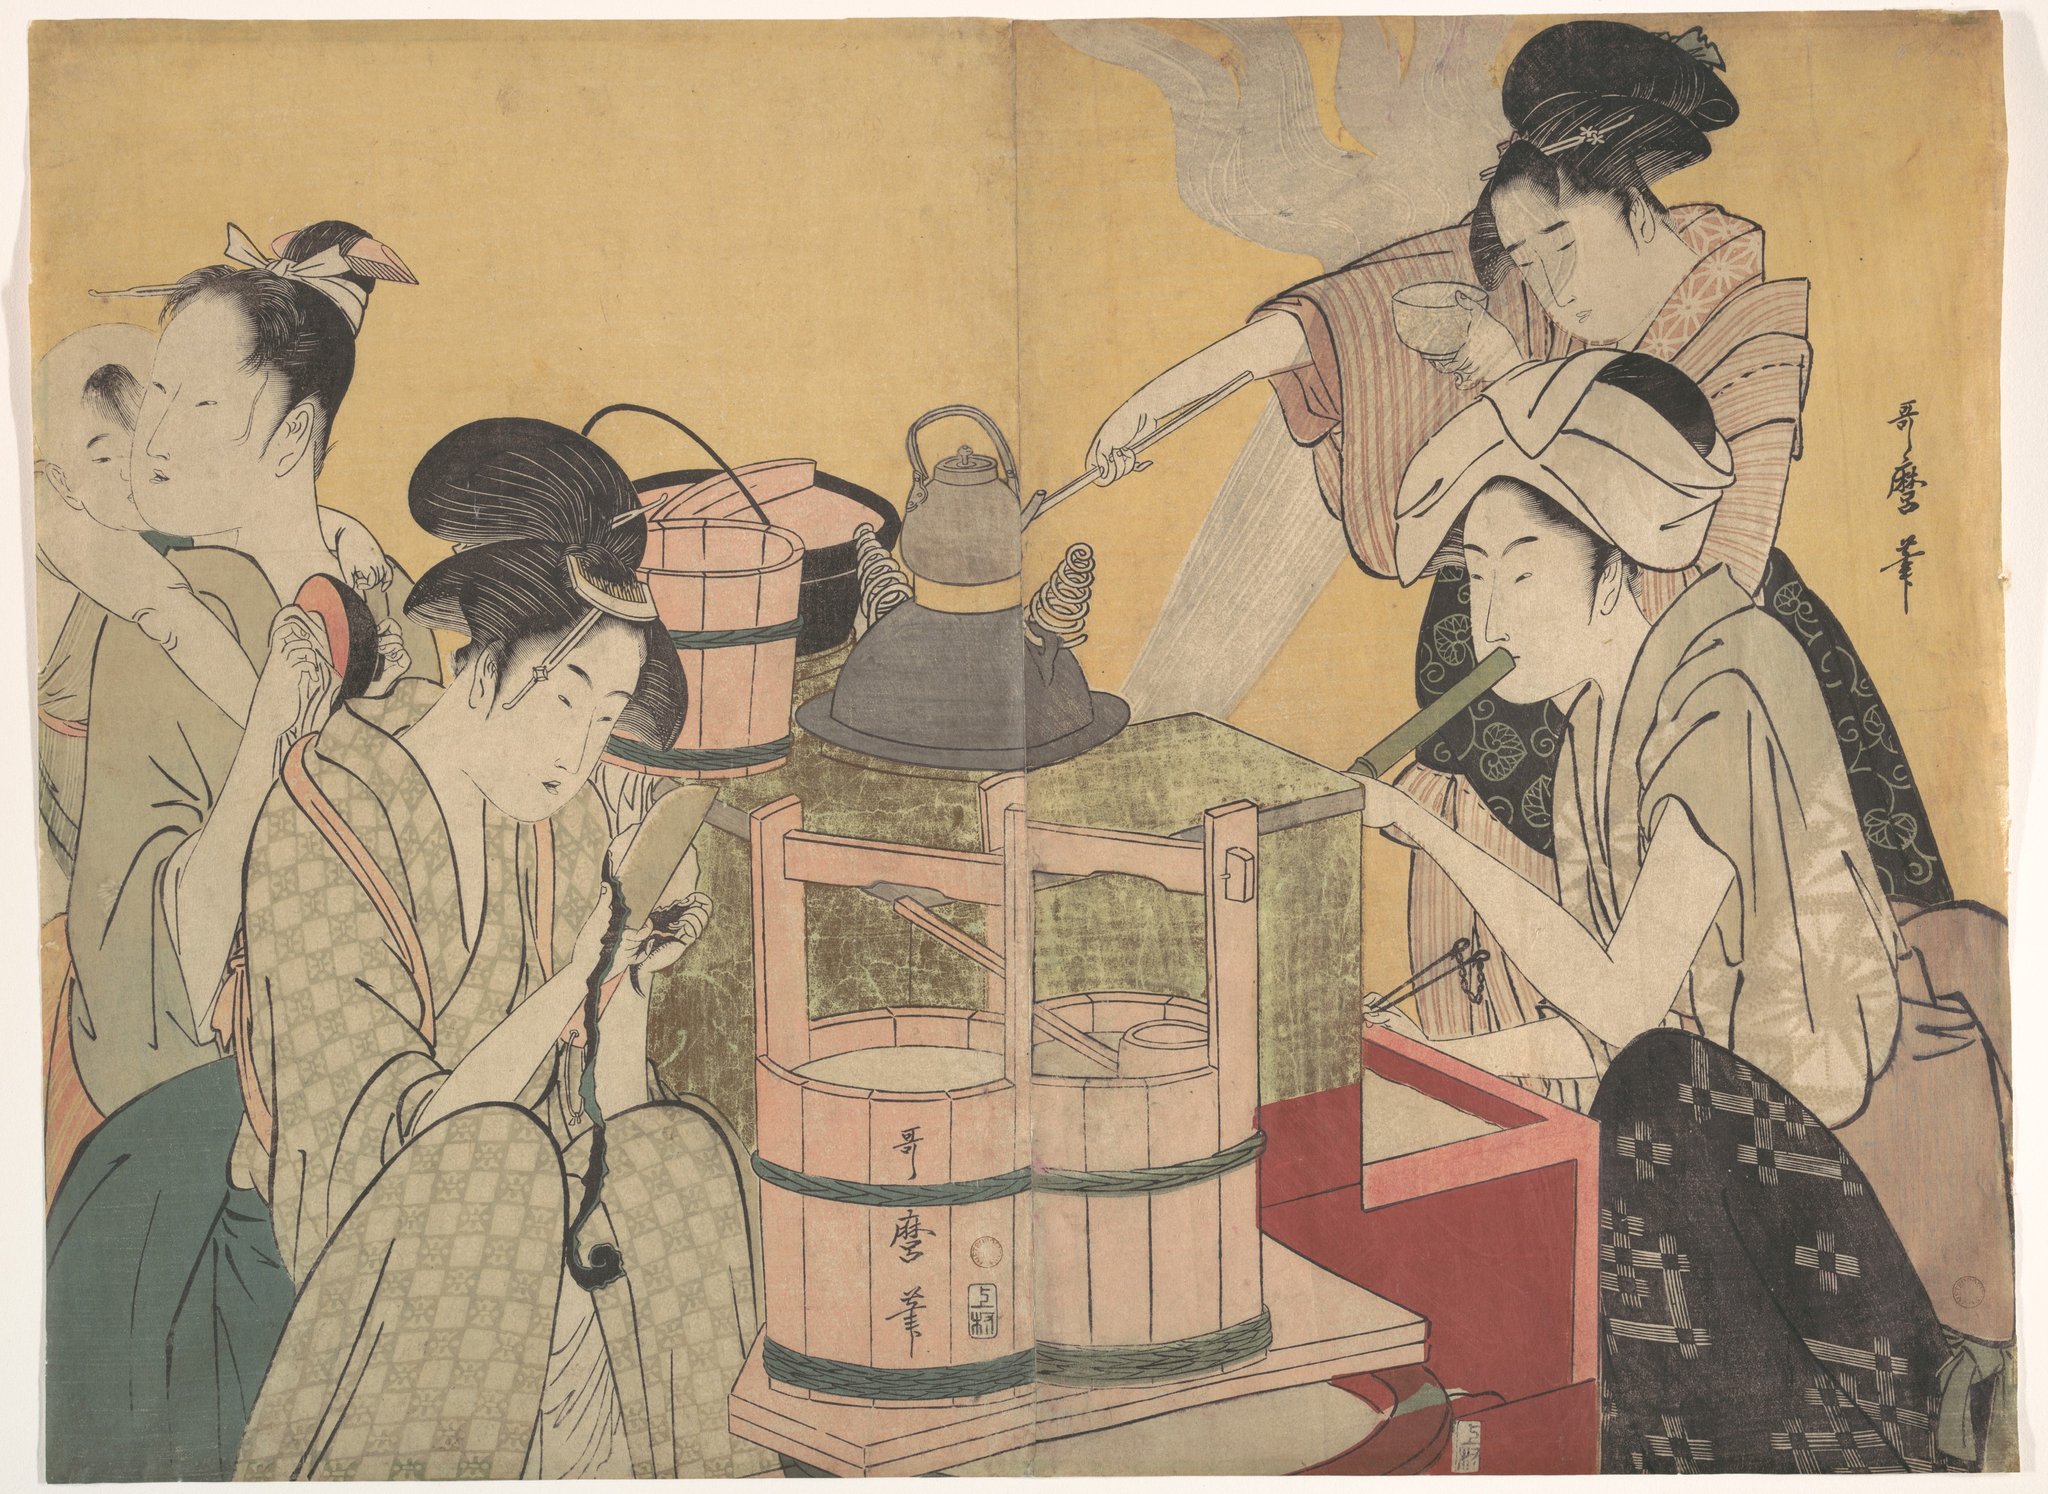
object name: print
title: Kitchen Scene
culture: japanese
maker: kitagawa utamaro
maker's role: artist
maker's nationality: japanese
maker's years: 1754-1806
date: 1794-1795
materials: ink, paper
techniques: woodblock print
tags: food,kitchens,children,women,cooking